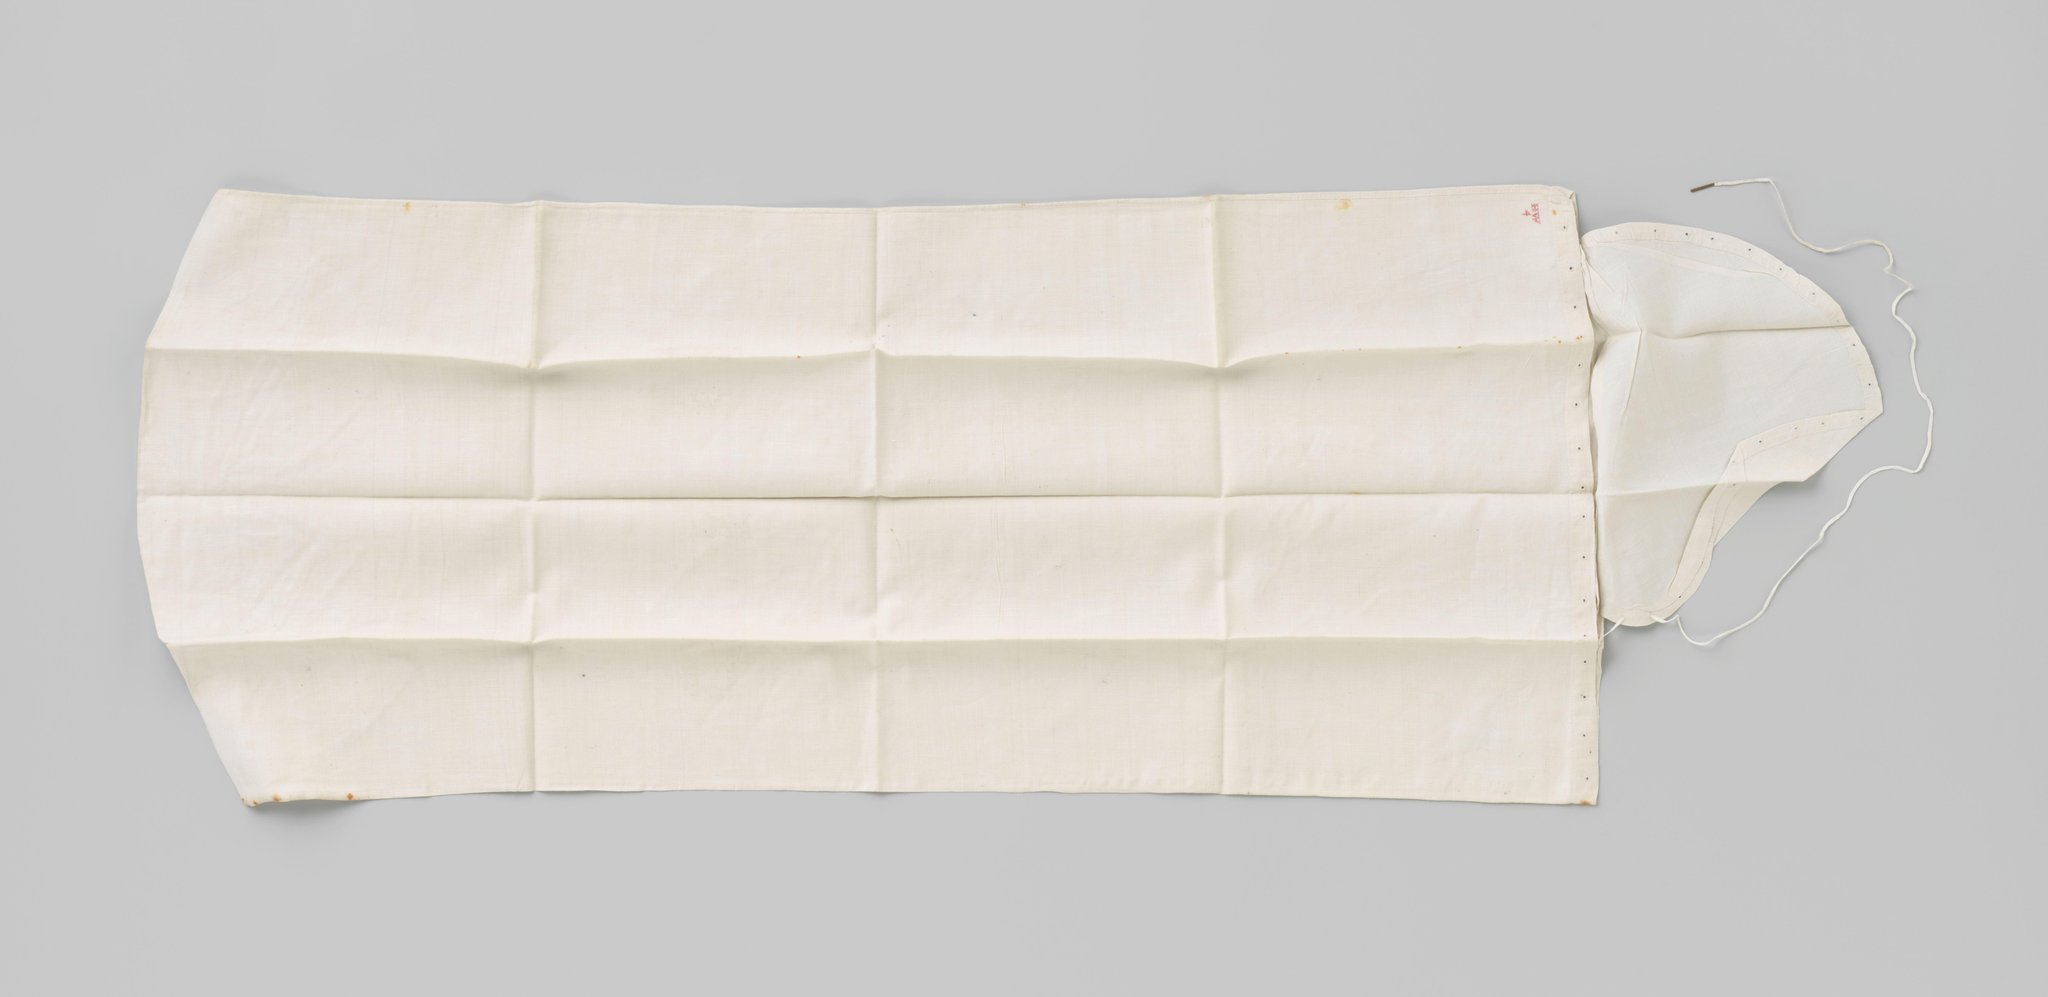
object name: rolsloop, rolkussenovertrek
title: Rolsloop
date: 1852-1872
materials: linen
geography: northern netherlands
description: Rolsloop van linnen met een gesloten uiteinde met een los sluitstuk, merk HW4.